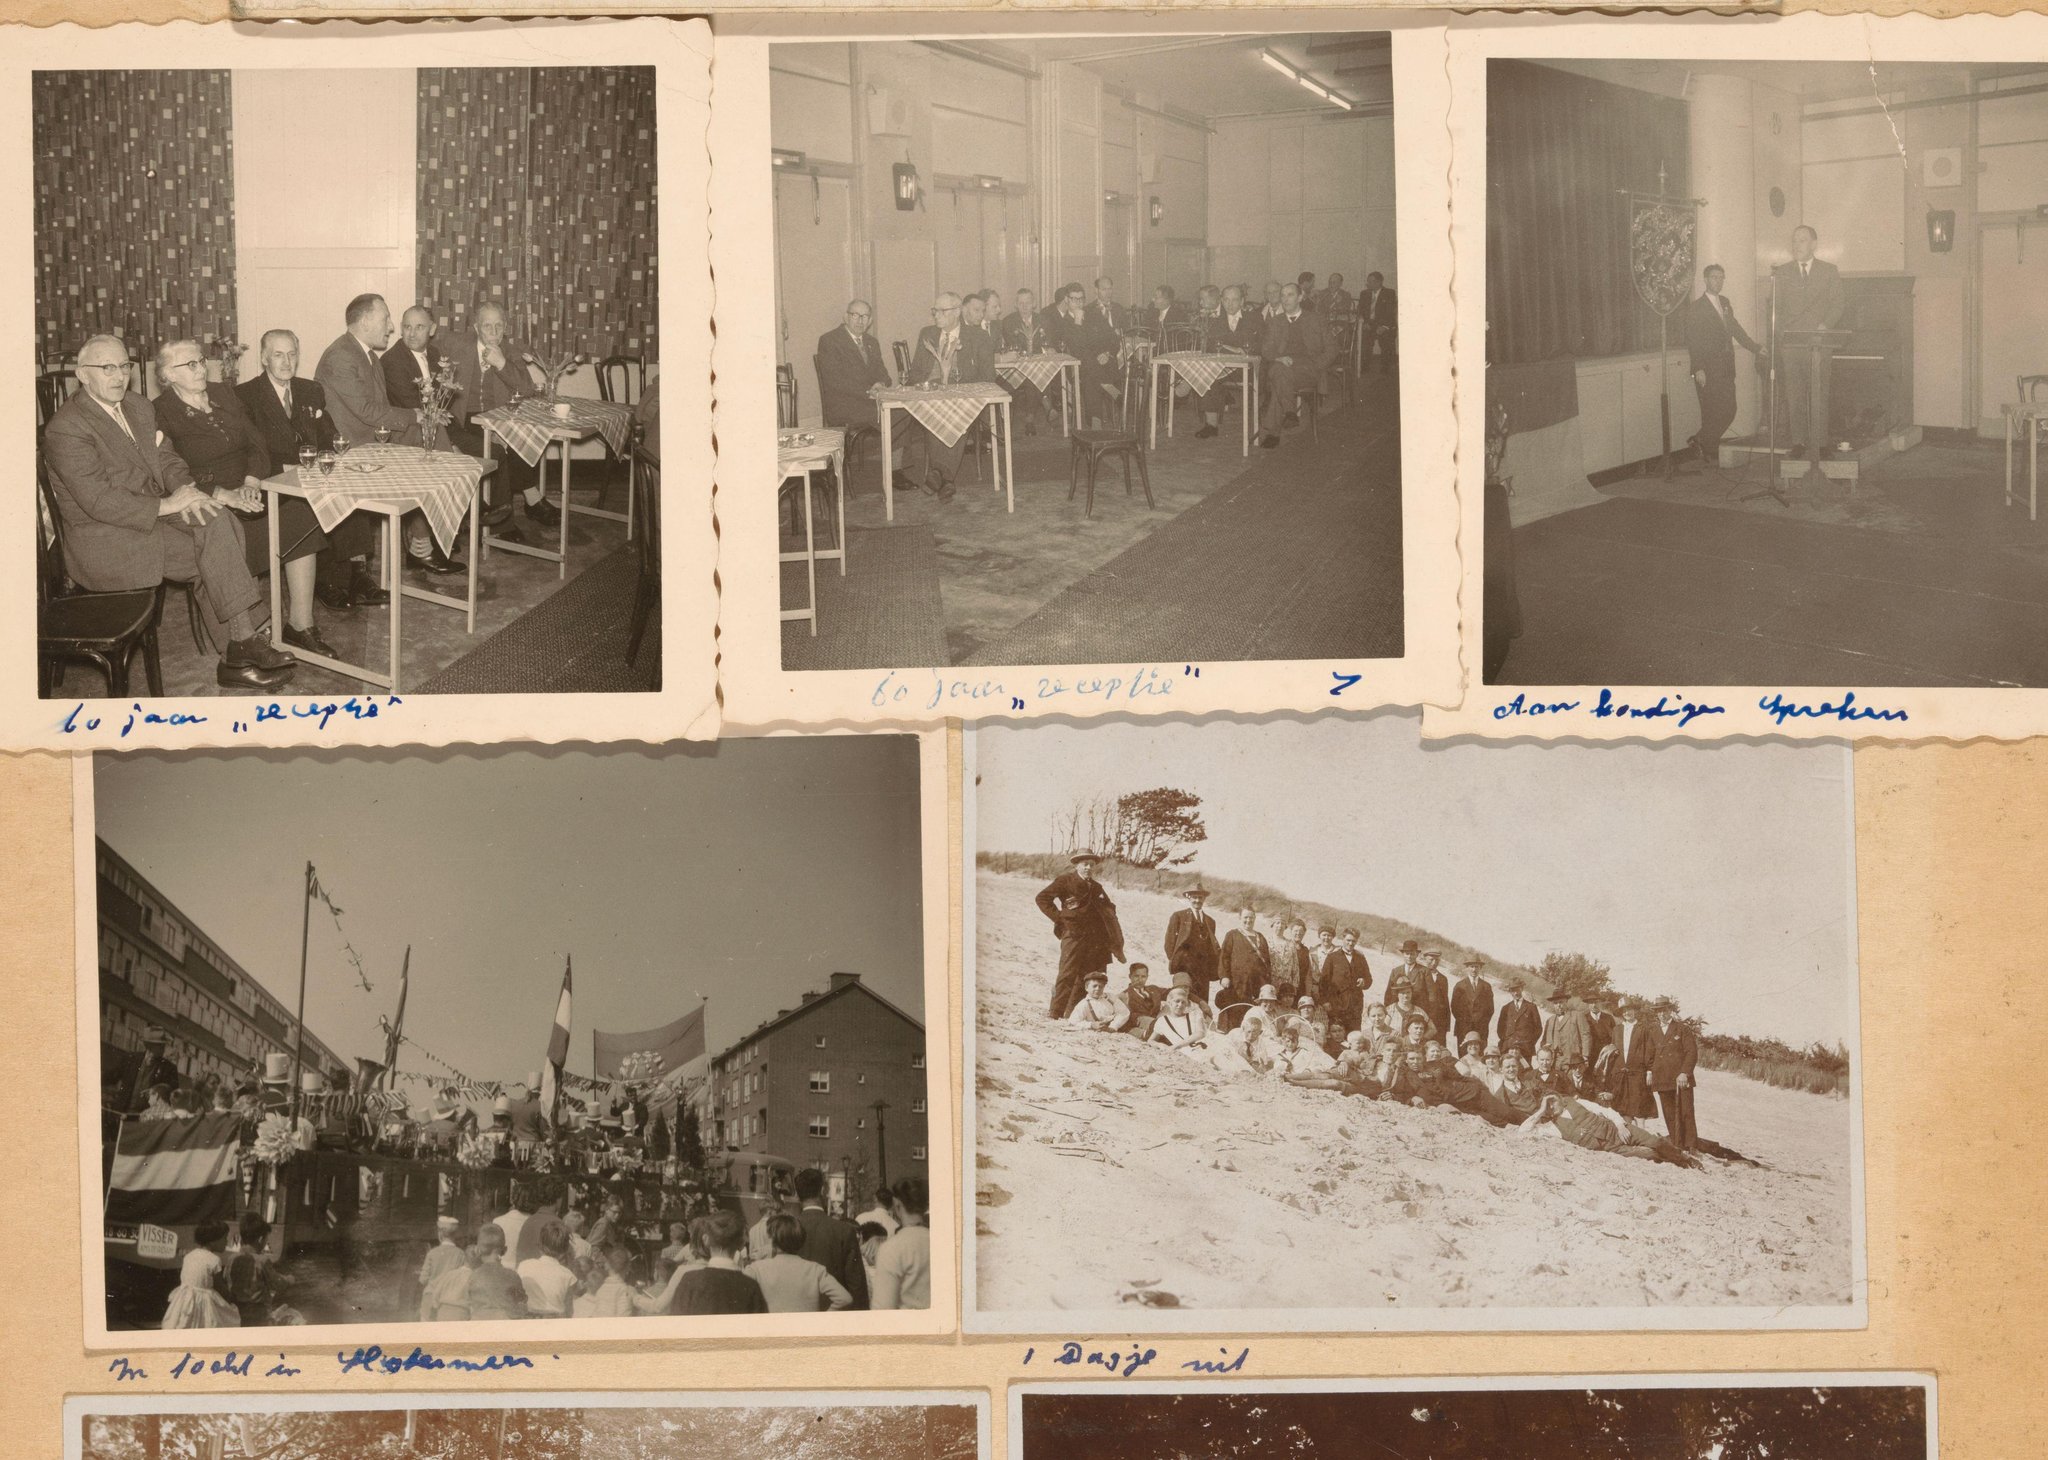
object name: photograph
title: 60 jaar receptie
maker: Anonymous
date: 1950-1970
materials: photographic support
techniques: gelatin silver print